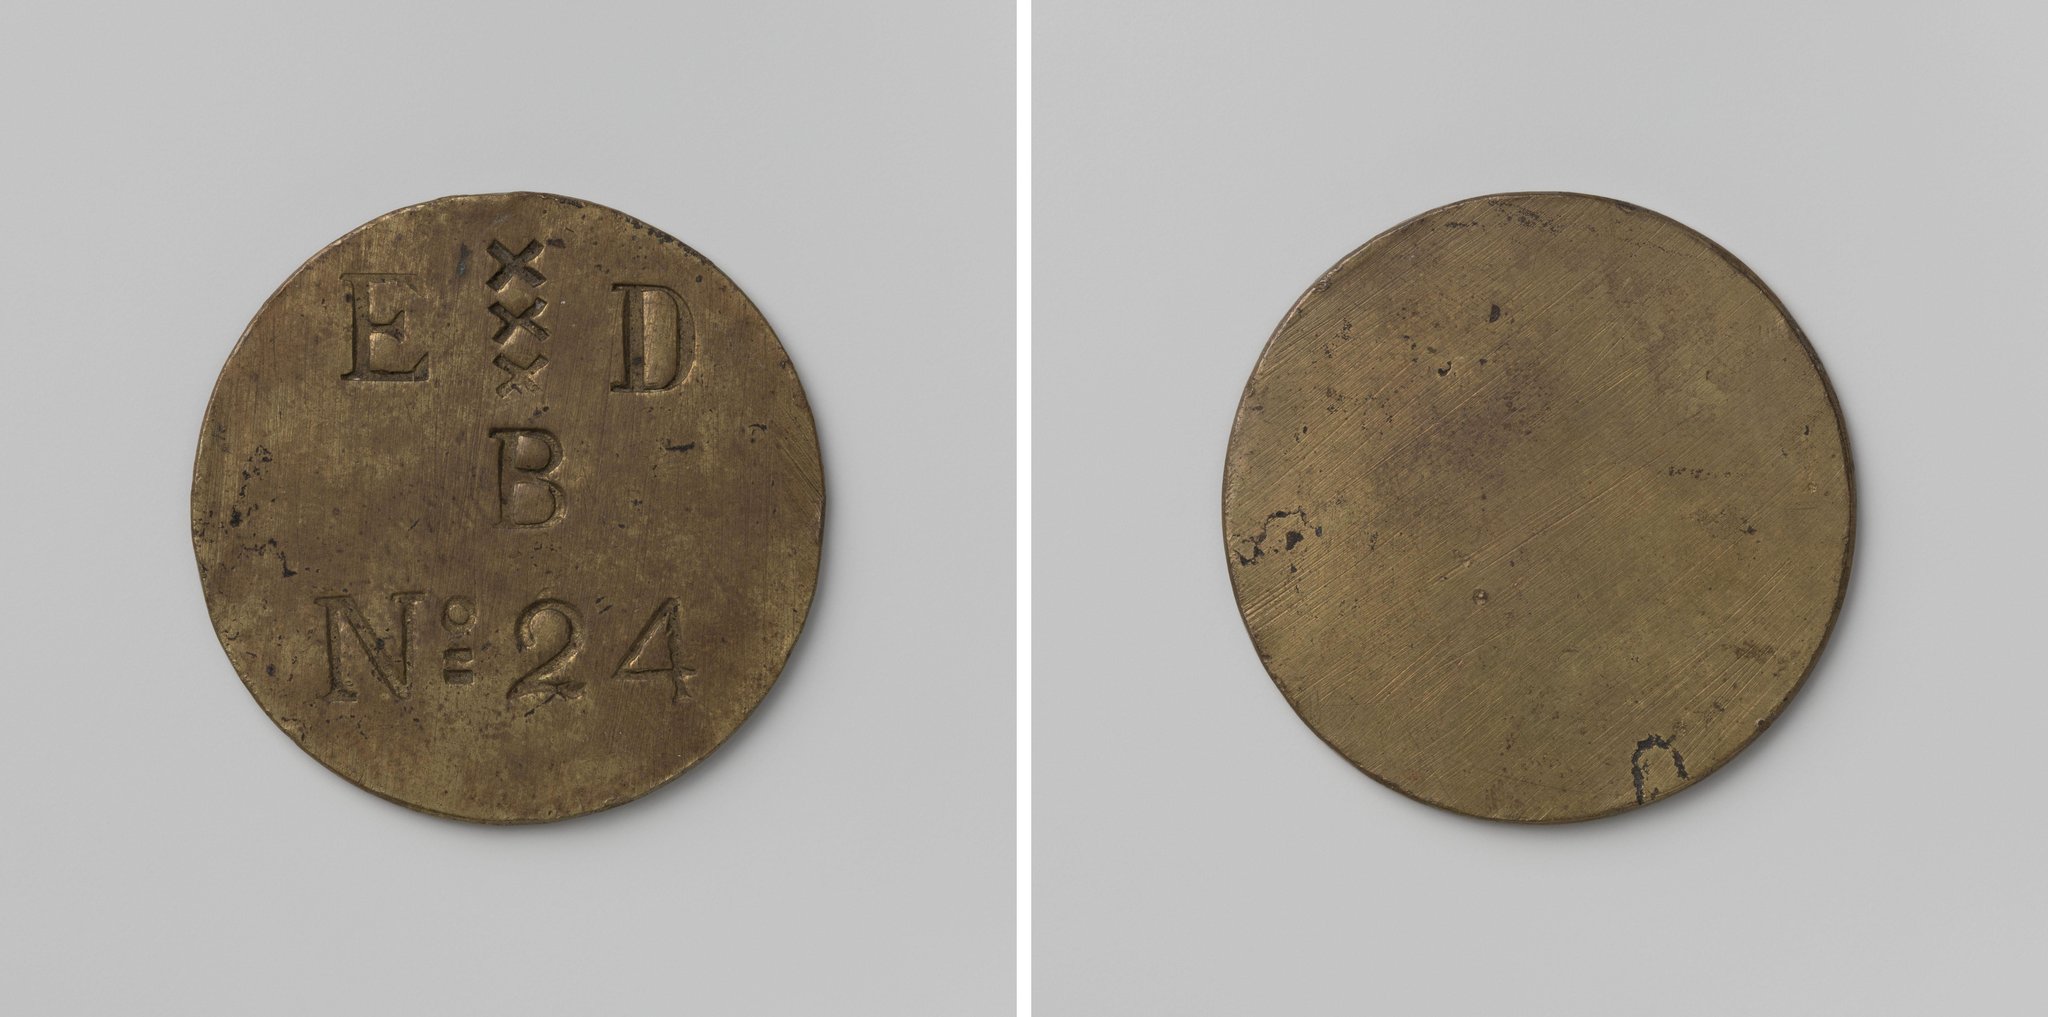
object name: medal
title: Amsterdam, brandspuitpenning met no. 24 en monogram E.D.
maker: Anonymous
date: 1800-1900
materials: brass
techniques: engraving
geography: amsterdam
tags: amsterdam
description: Eenzijdige messing penning. Voorzijde: opschrift E D, onderbroken door drie boven elkaar geplaatste kruisjes; daaronder: letter B en opschrift No. 24. Keerzijde: blanco